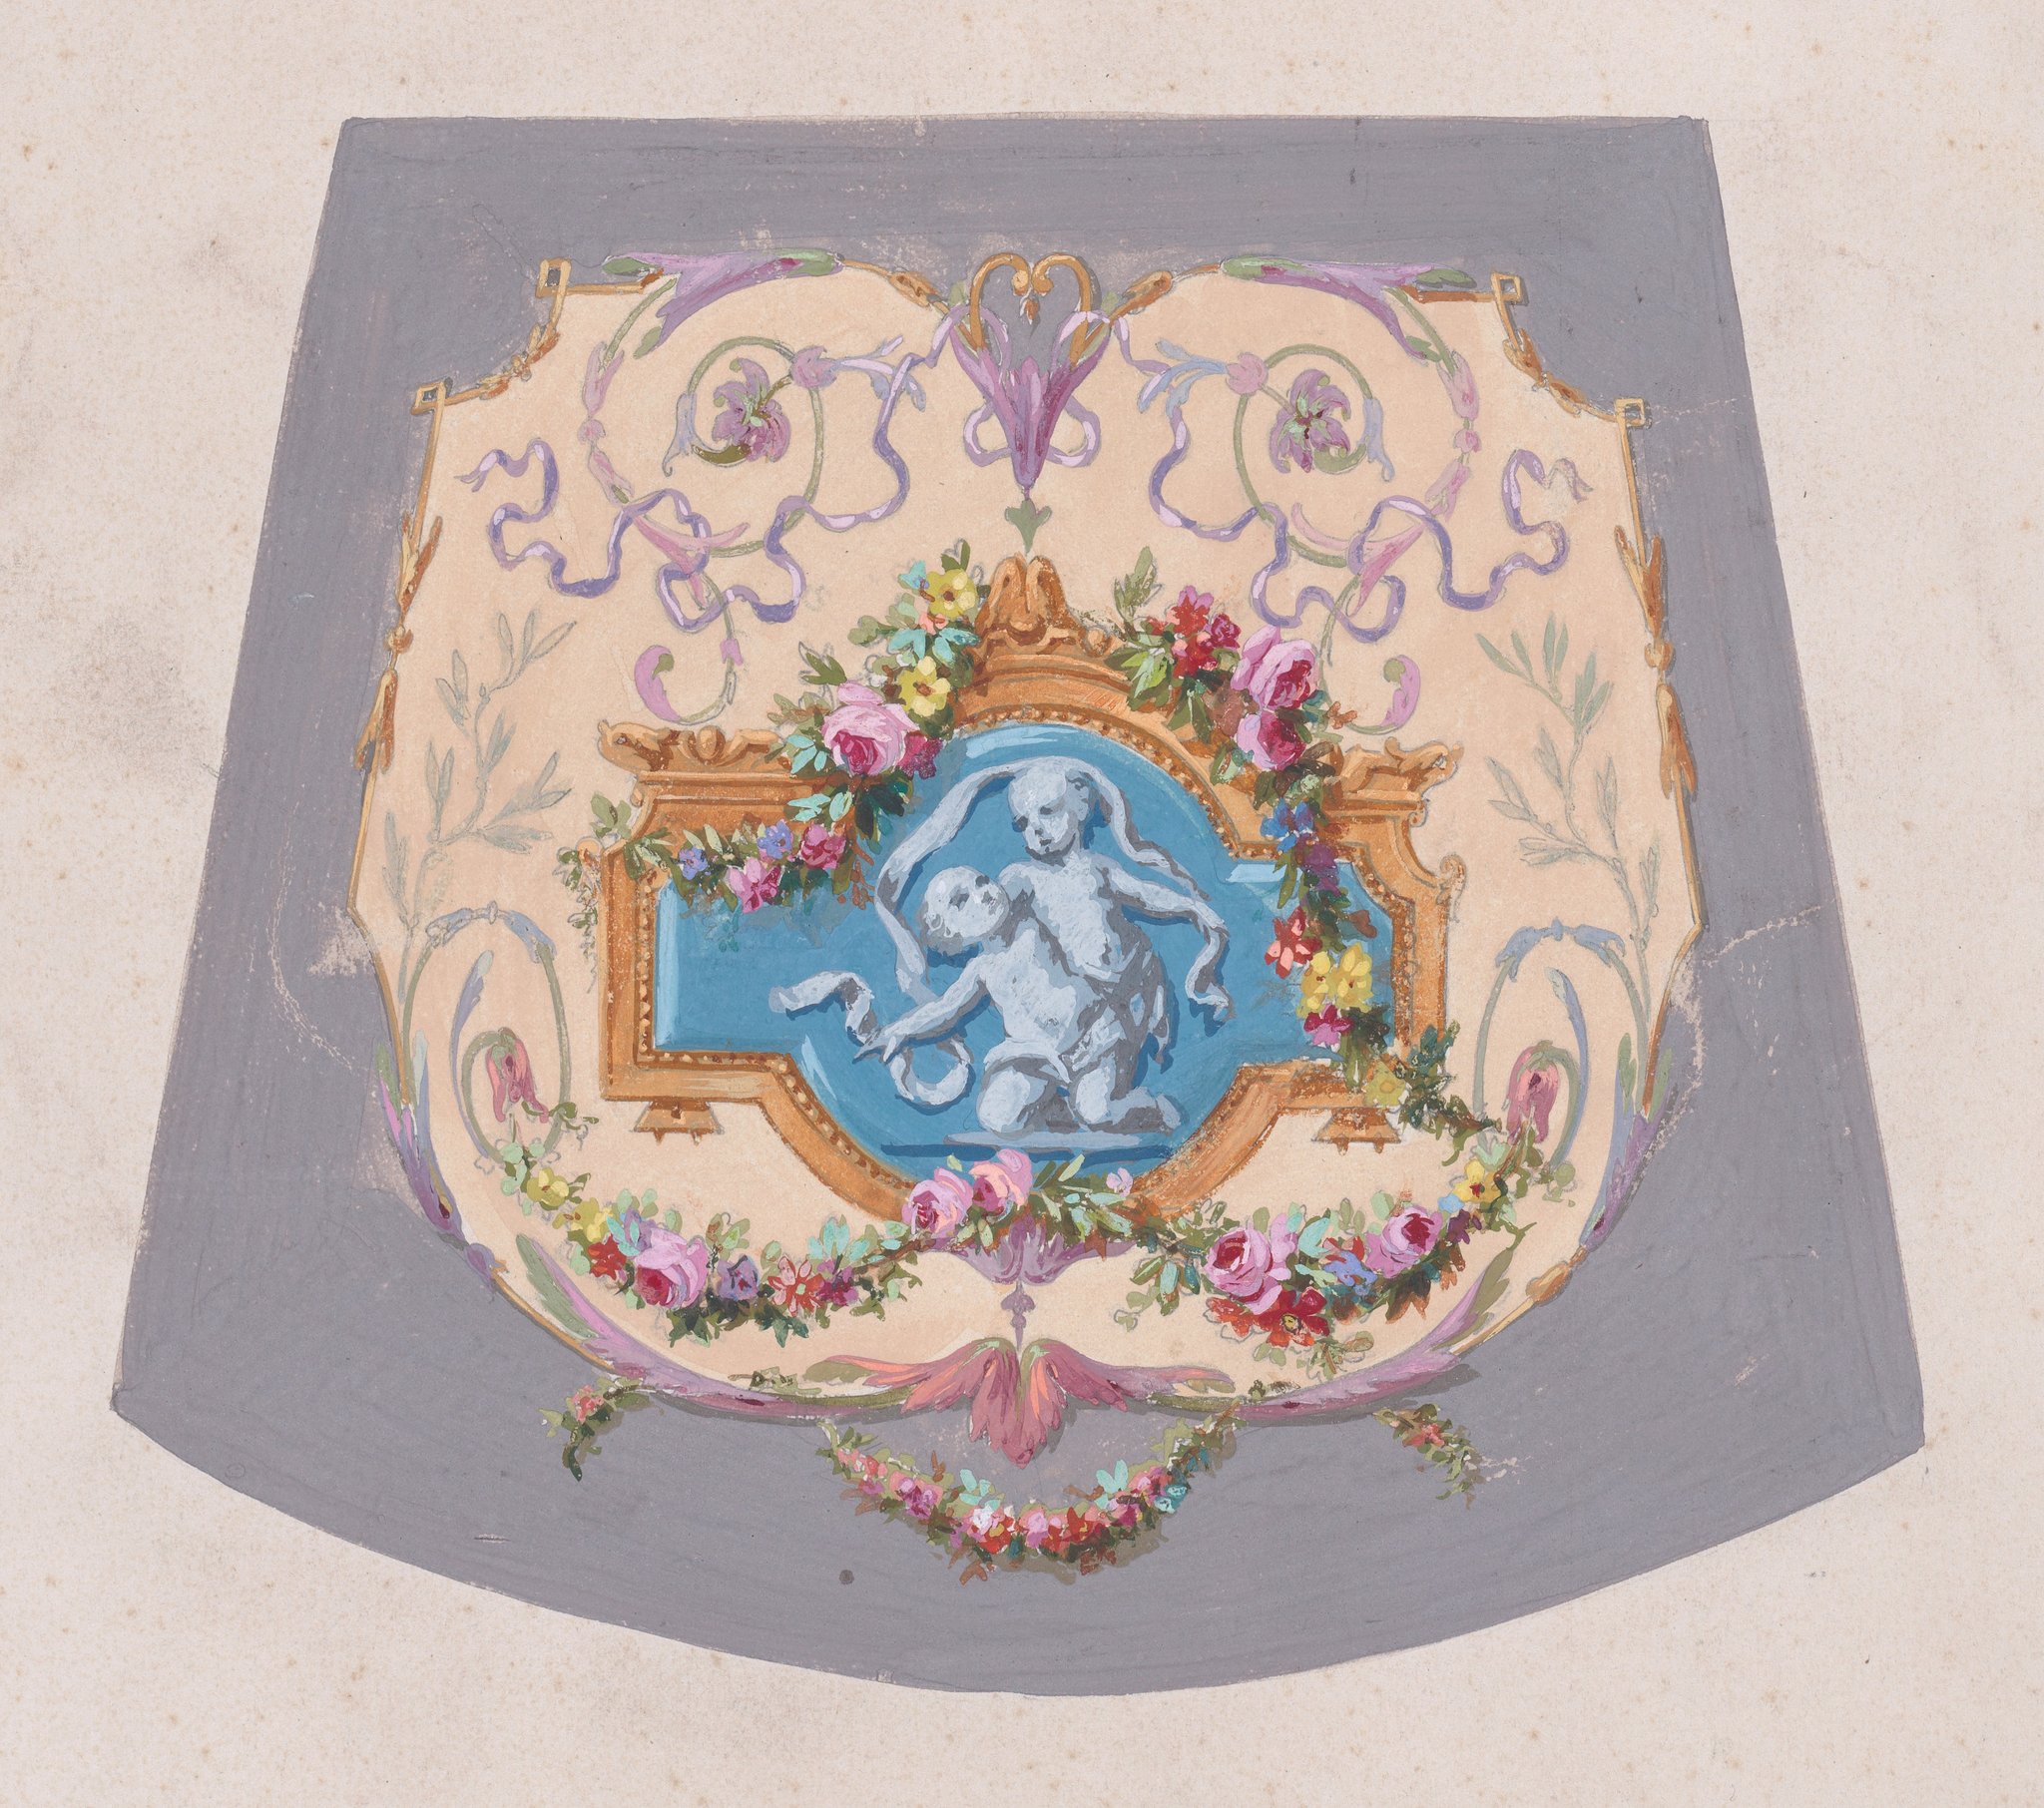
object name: drawing ornament architecture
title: Design for a Chair Seat Cover with an Ornamental Frame with Two Restling Putti with Hanging Garlands of Leaves and Flowers Inside a Larger Ornamental Frame Featuring a Heart-Shape Motif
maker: anonymous, french, 19th century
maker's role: designer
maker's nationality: french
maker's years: 1800-1900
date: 1870-1900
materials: gouache, watercolor